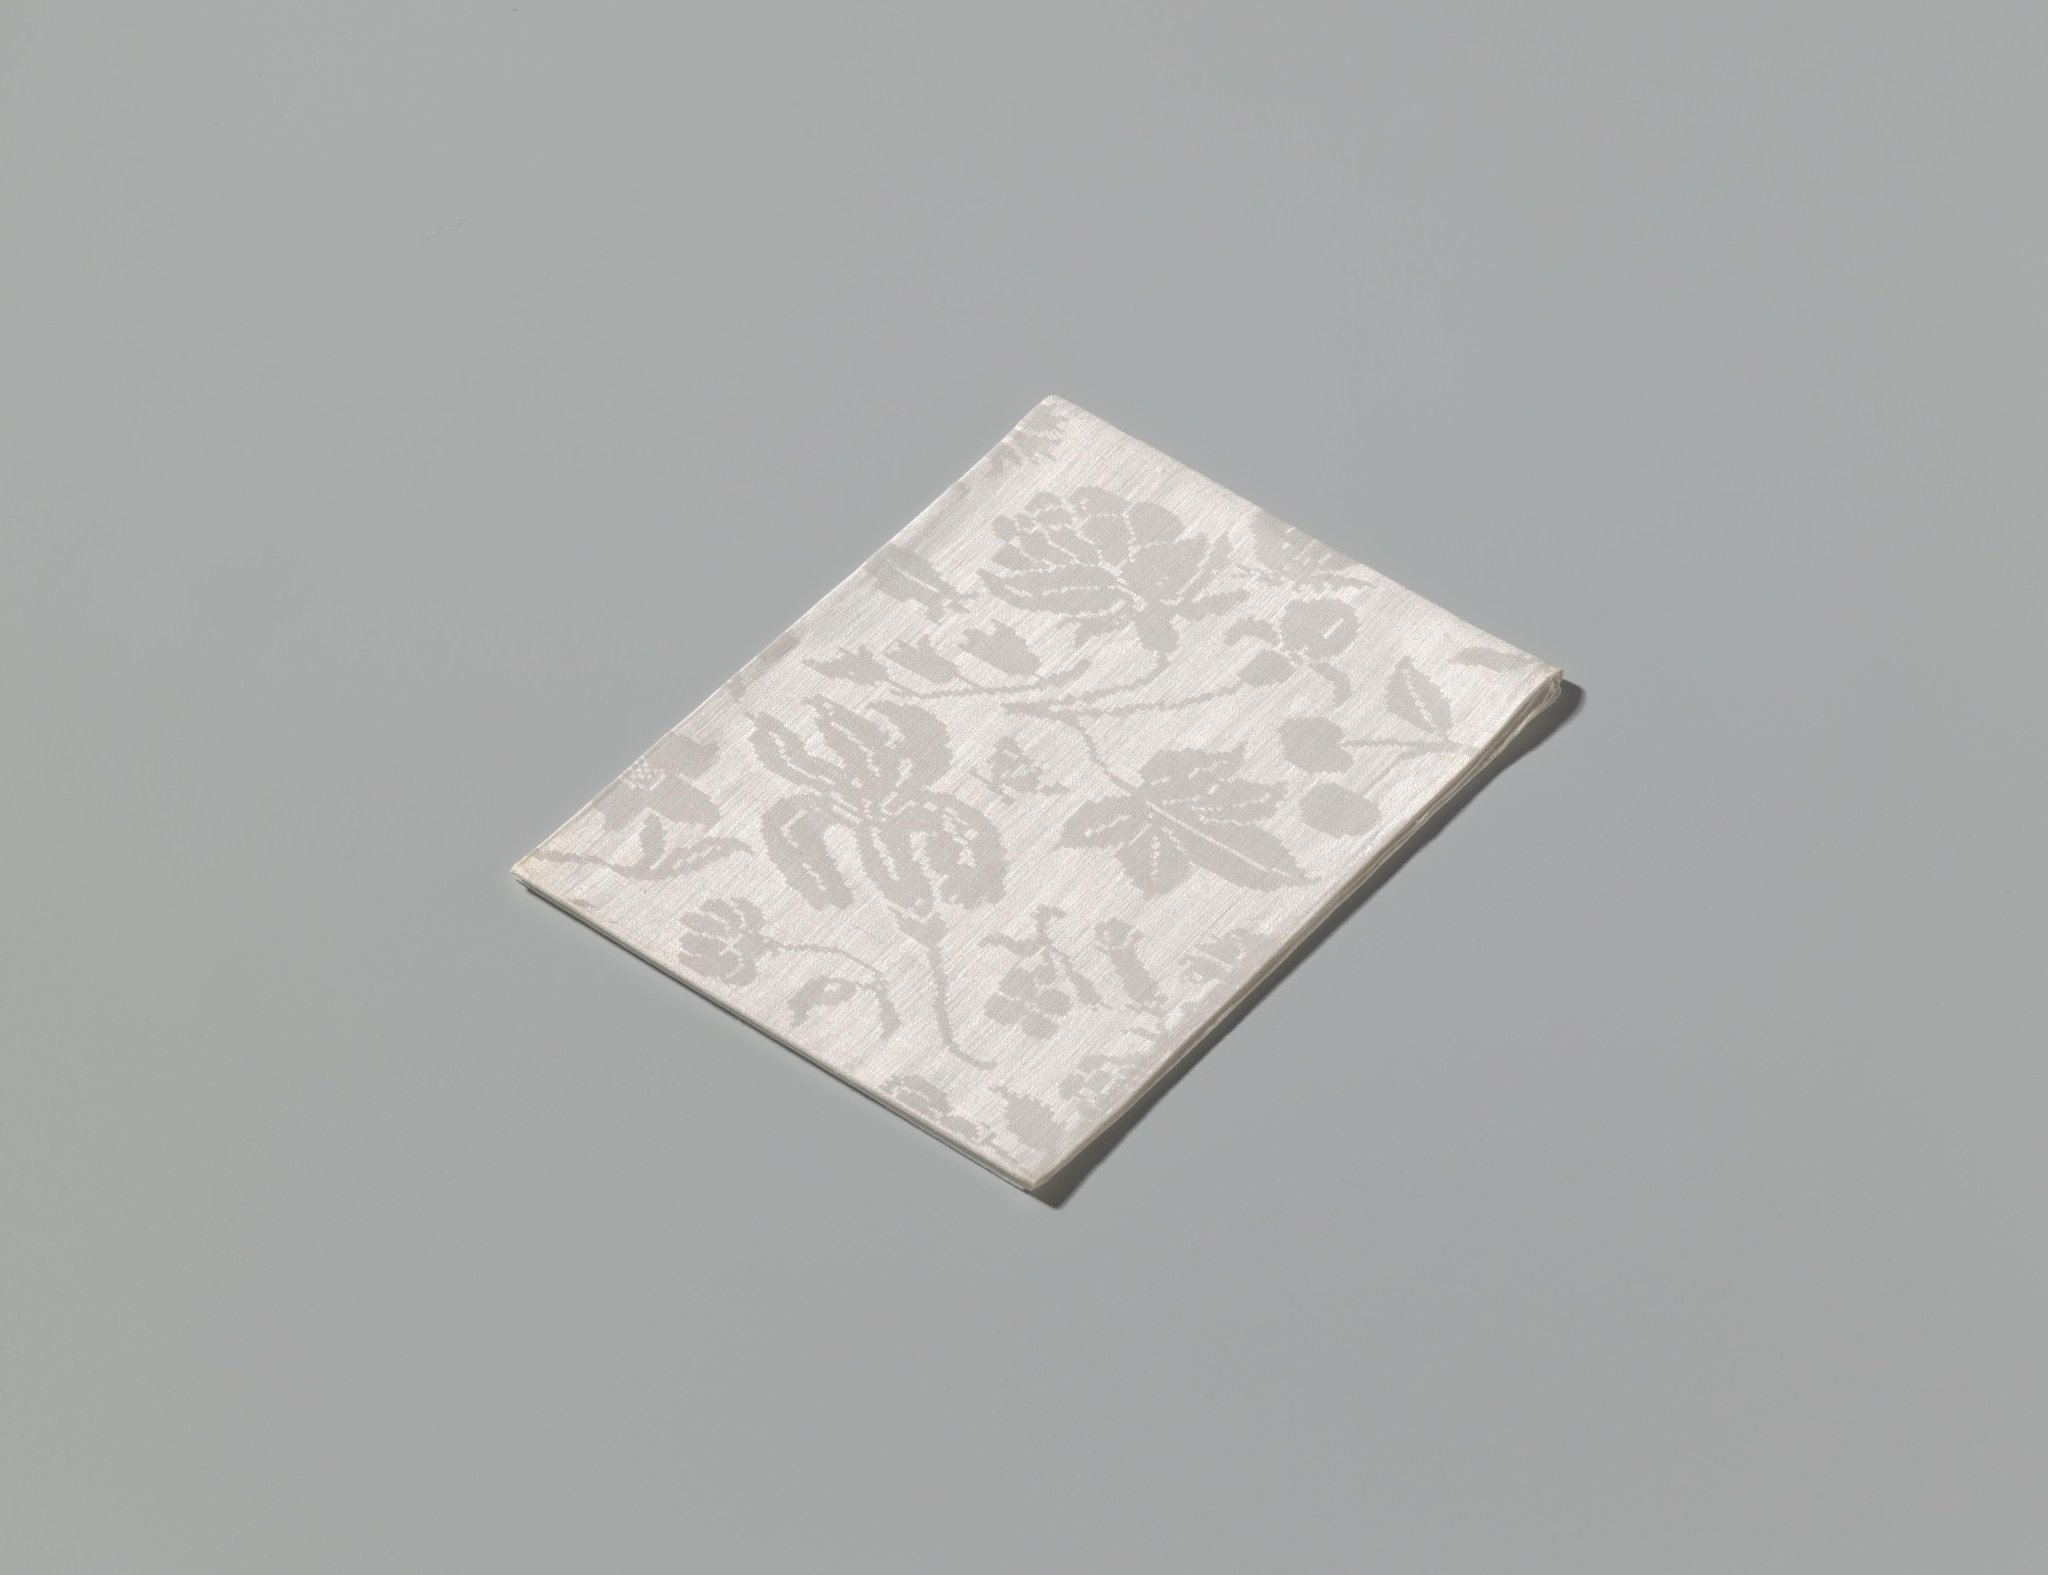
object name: napkin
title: Servet met gestrooide bloemen en insekten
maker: Anonymous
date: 1640-1650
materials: linen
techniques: damask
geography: northern netherlands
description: Wit linnendamasten servet met patroon van gestrooide bloemen en insecten, merk kroon WG 31. Hoort bij servet BK-1980-359-A.